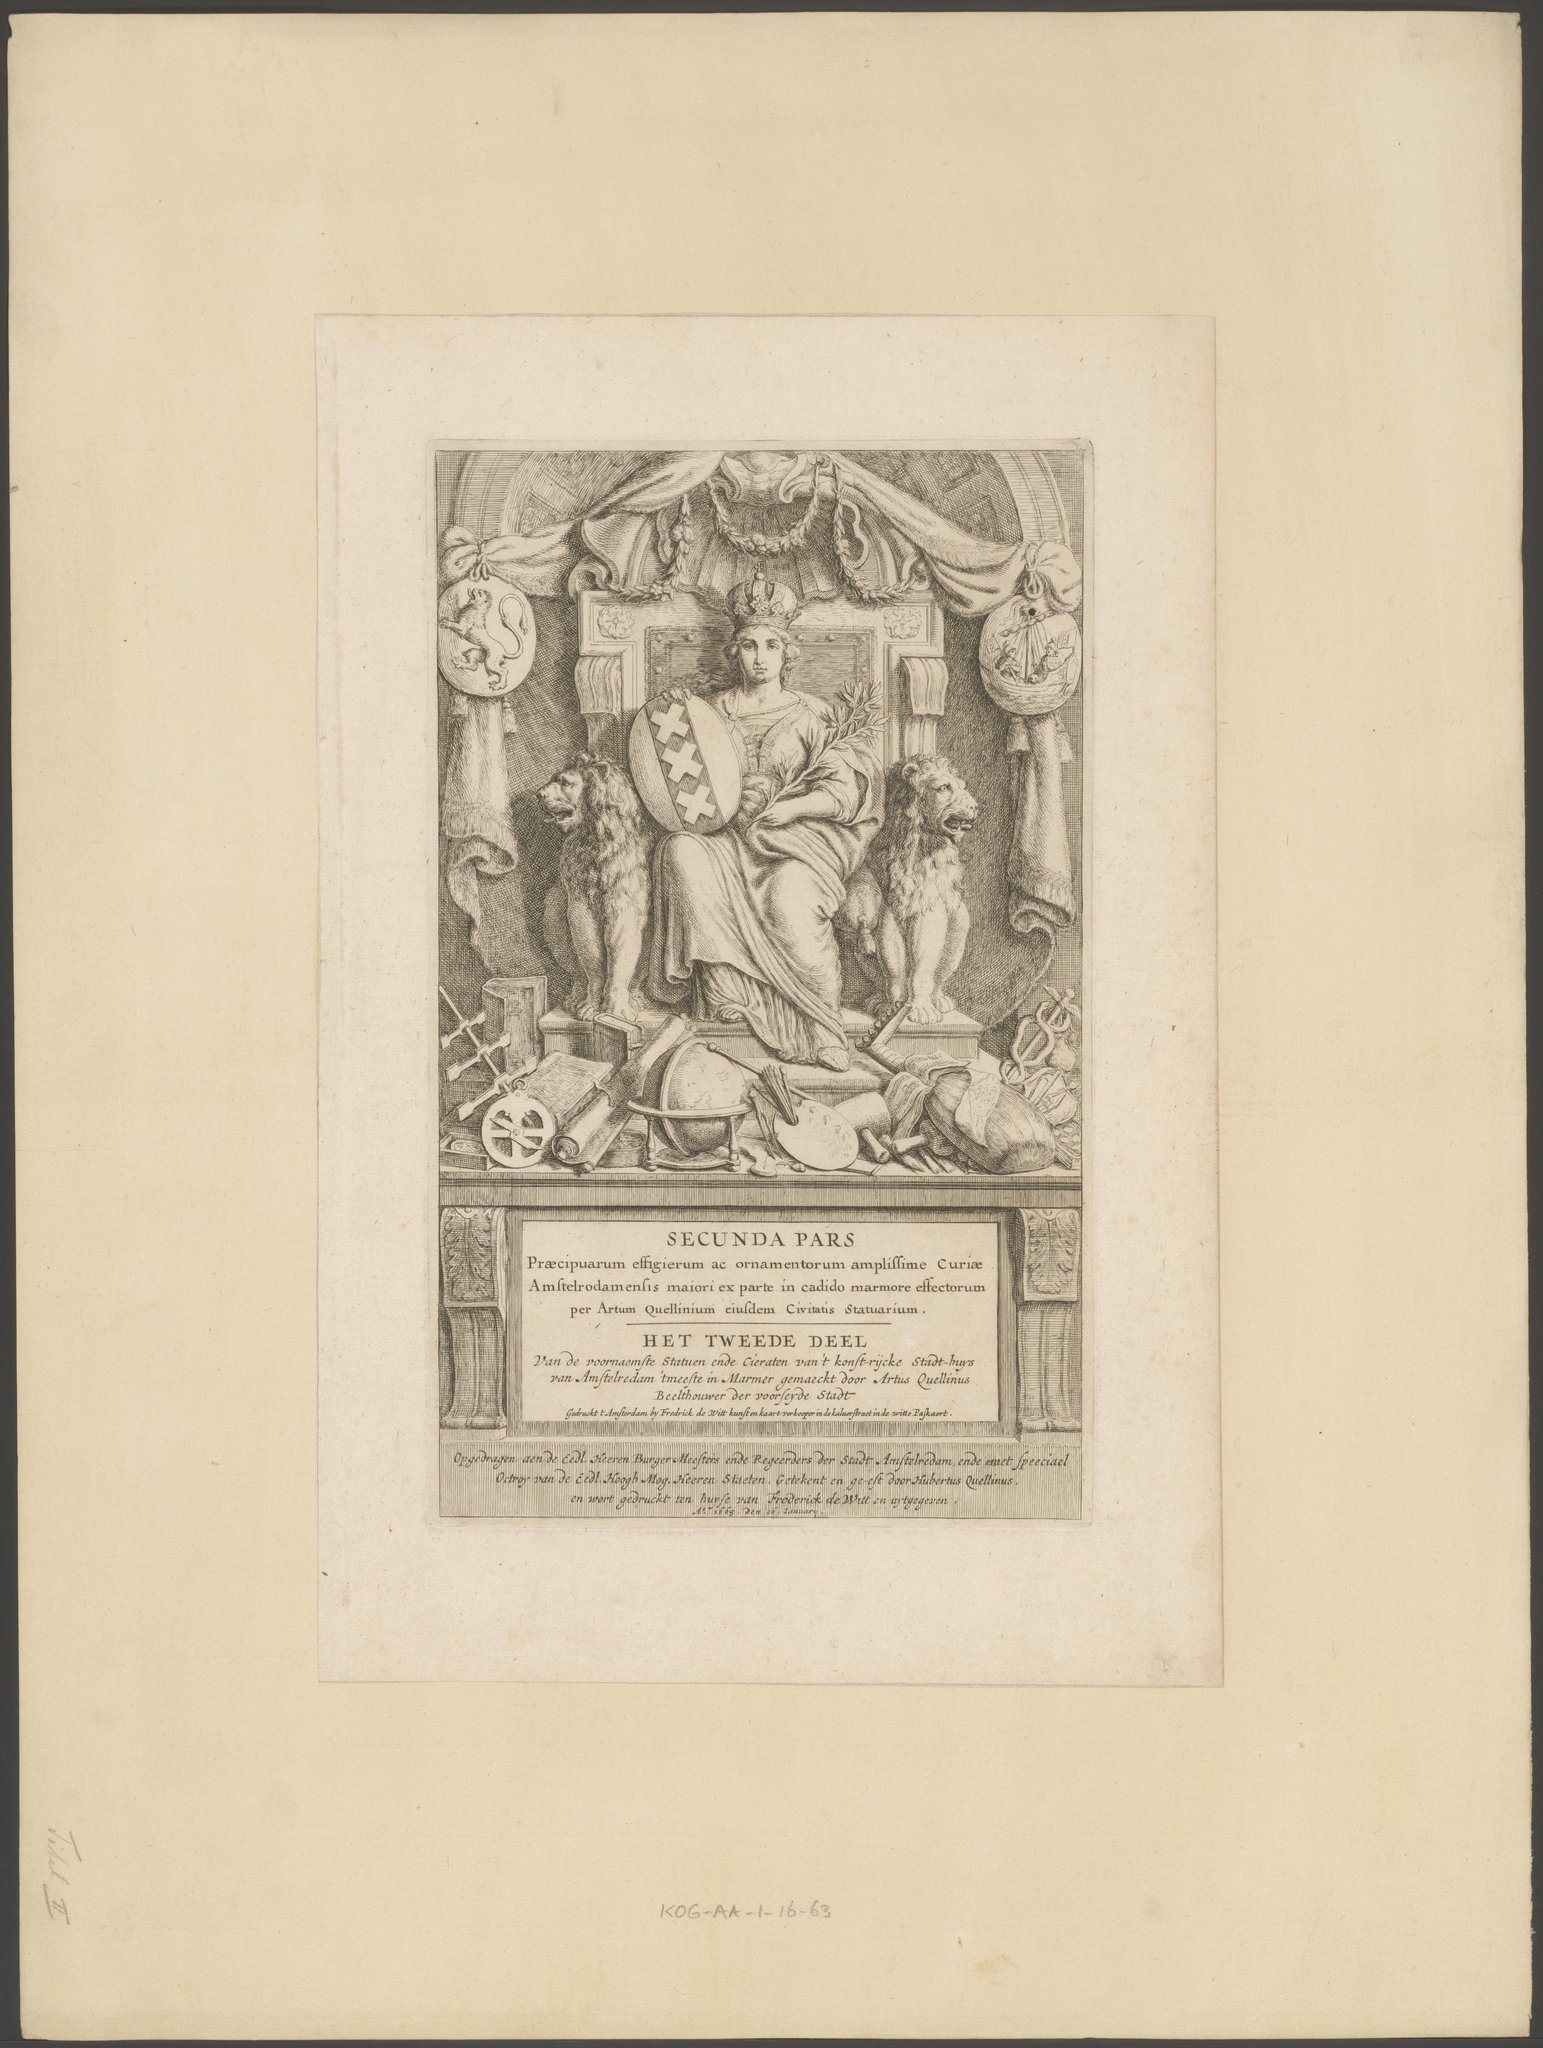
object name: print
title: Amsterdamse Stedenmaagd geflankeerd door twee leeuwen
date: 1668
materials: paper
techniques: engraving, etching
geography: amsterdam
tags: the arts; artists, coat of arms (as symbol of the state, etc.) (+ city; municipal), seal (as symbol of the state, etc.) (+ city; municipal), townhall, professor, trade, commerce and finance, position-finding at sea; nautical instruments, coat of arms (as symbol of the state, etc.) (+ province; provincial)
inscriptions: collector's mark: ‘16,63’ Lugt 1641b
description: Prent gebruikt in: Latere staat van prent ook gebruikt in: Secunca pars Praecipuarum effigierum ac ornamentorum amplissime Curiae Amstelrodamensis maiori ex parte in cadido marmore effectorum per Artum Quellinium eiusdem Civitatis Statuarium / Het tweede deel Van de voornaemste Statuen ende Cieraten van 't konst-rijcke Stadt-huys van Amstelredam 'tmeeste in Marmer gemaeckt door Artus Quellinus Beelthouwer der voorseyde Stadt. Amsterdam: Frederik de Wit, 1668. Zie RP-P-AO-22-2-2 voor bijhorend register. Zie RP-P-AO-22-2A, RP-P-AO-22-2B, RP-P-AO-22-2C-1, RP-P-AO-22-2C-2, RP-P-AO-22-2C-3, RP-P-AO-22-2C-4, RP-P-AO-22-2D-1, RP-P-AO-22-2D-2, RP-P-AO-22-2D-3, RP-P-AO-22-2E-1, RP-P-AO-22-2E-2, RP-P-AO-22-2E-3, RP-P-AO-22-2E-4, RP-P-AO-22-2F-1, RP-P-AO-22-2F-2, RP-P-AO-22-2F-3, RP-P-AO-22-2G, RP-P-AO-22-2H, RP-P-AO-22-2I, RP-P-AO-22-2K, RP-P-AO-22-2L, RP-P-AO-22-2M, RP-P-AO-22-2N, RP-P-AO-22-2O-1, RP-P-AO-22-2O-2, RP-P-AO-22-2O-3, RP-P-AO-22-2O-4, RP-P-AO-22-2O-5, RP-P-AO-22-2O-6, RP-P-AO-22-2O-7, RP-P-AO-22-2P-1, RP-P-AO-22-2P-2, RP-P-AO-22-2Q-1, RP-P-AO-22-2Q-2, RP-P-AO-22-2Q-3, RP-P-AO-22-2R-1, RP-P-AO-22-2R-2, RP-P-AO-22-2R-3, RP-P-AO-22-2S, RP-P-AO-22-2T-1, RP-P-AO-22-2T-2, RP-P-AO-22-2T-3, RP-P-AO-22-2T-4, RP-P-AO-22-2V-1, RP-P-AO-22-2V-2, RP-P-AO-22-2W-1, RP-P-AO-22-2W-2, RP-P-AO-22-2X-1, RP-P-AO-22-2X-2 en RP-P-AO-22-2X-3 voor prenten uit deze publicatie. Eerdere staat van prent ook gebruikt in: Secunca pars Praecipuarum effigierum ac ornamentorum amplissime Curiae Amstelrodamensis maiori ex parte in cadido marmore effectorum per Artum Quellinium eiusdem Civitatis Statuarium / Het tweede deel Van de voornaemste Statuen ende Cieraten van 't konst-rijcke Stadt-huys van Amstelredam 'tmeeste in Marmer gemaeckt door Artus Quellinus Beelthouwer der voorseyde Stadt. Amsterdam: Artus Quellinus (I), 1663. Zie RP-P-AO-22-1-1 voor titelpagina van eerste deel.